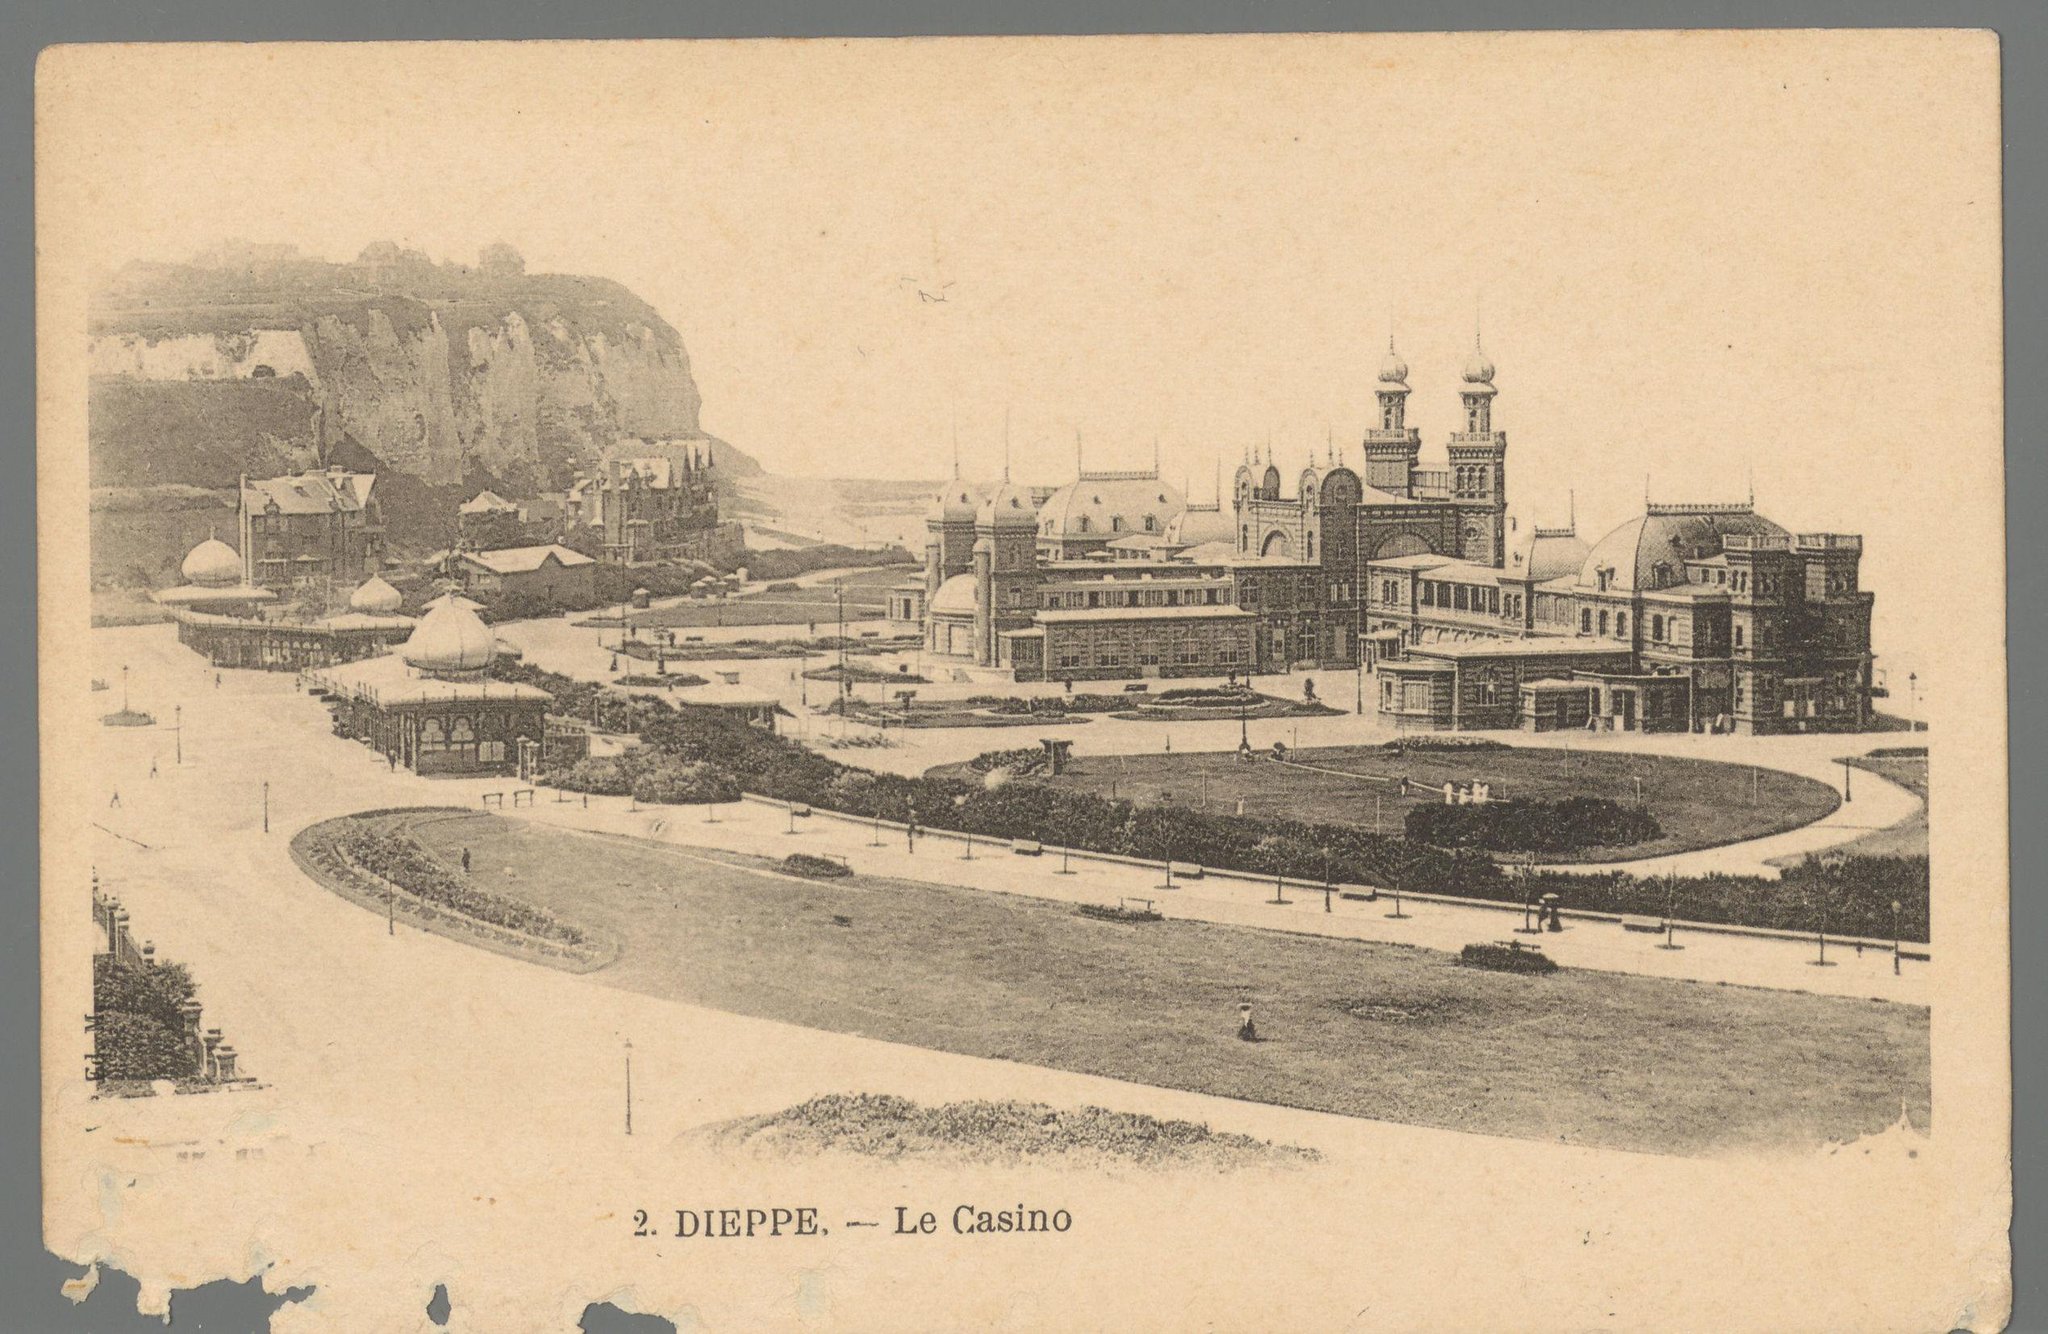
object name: photomechanical print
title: Dieppe. - Le Casino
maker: Anonymous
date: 1870-1904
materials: cardboard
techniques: photograph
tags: casino